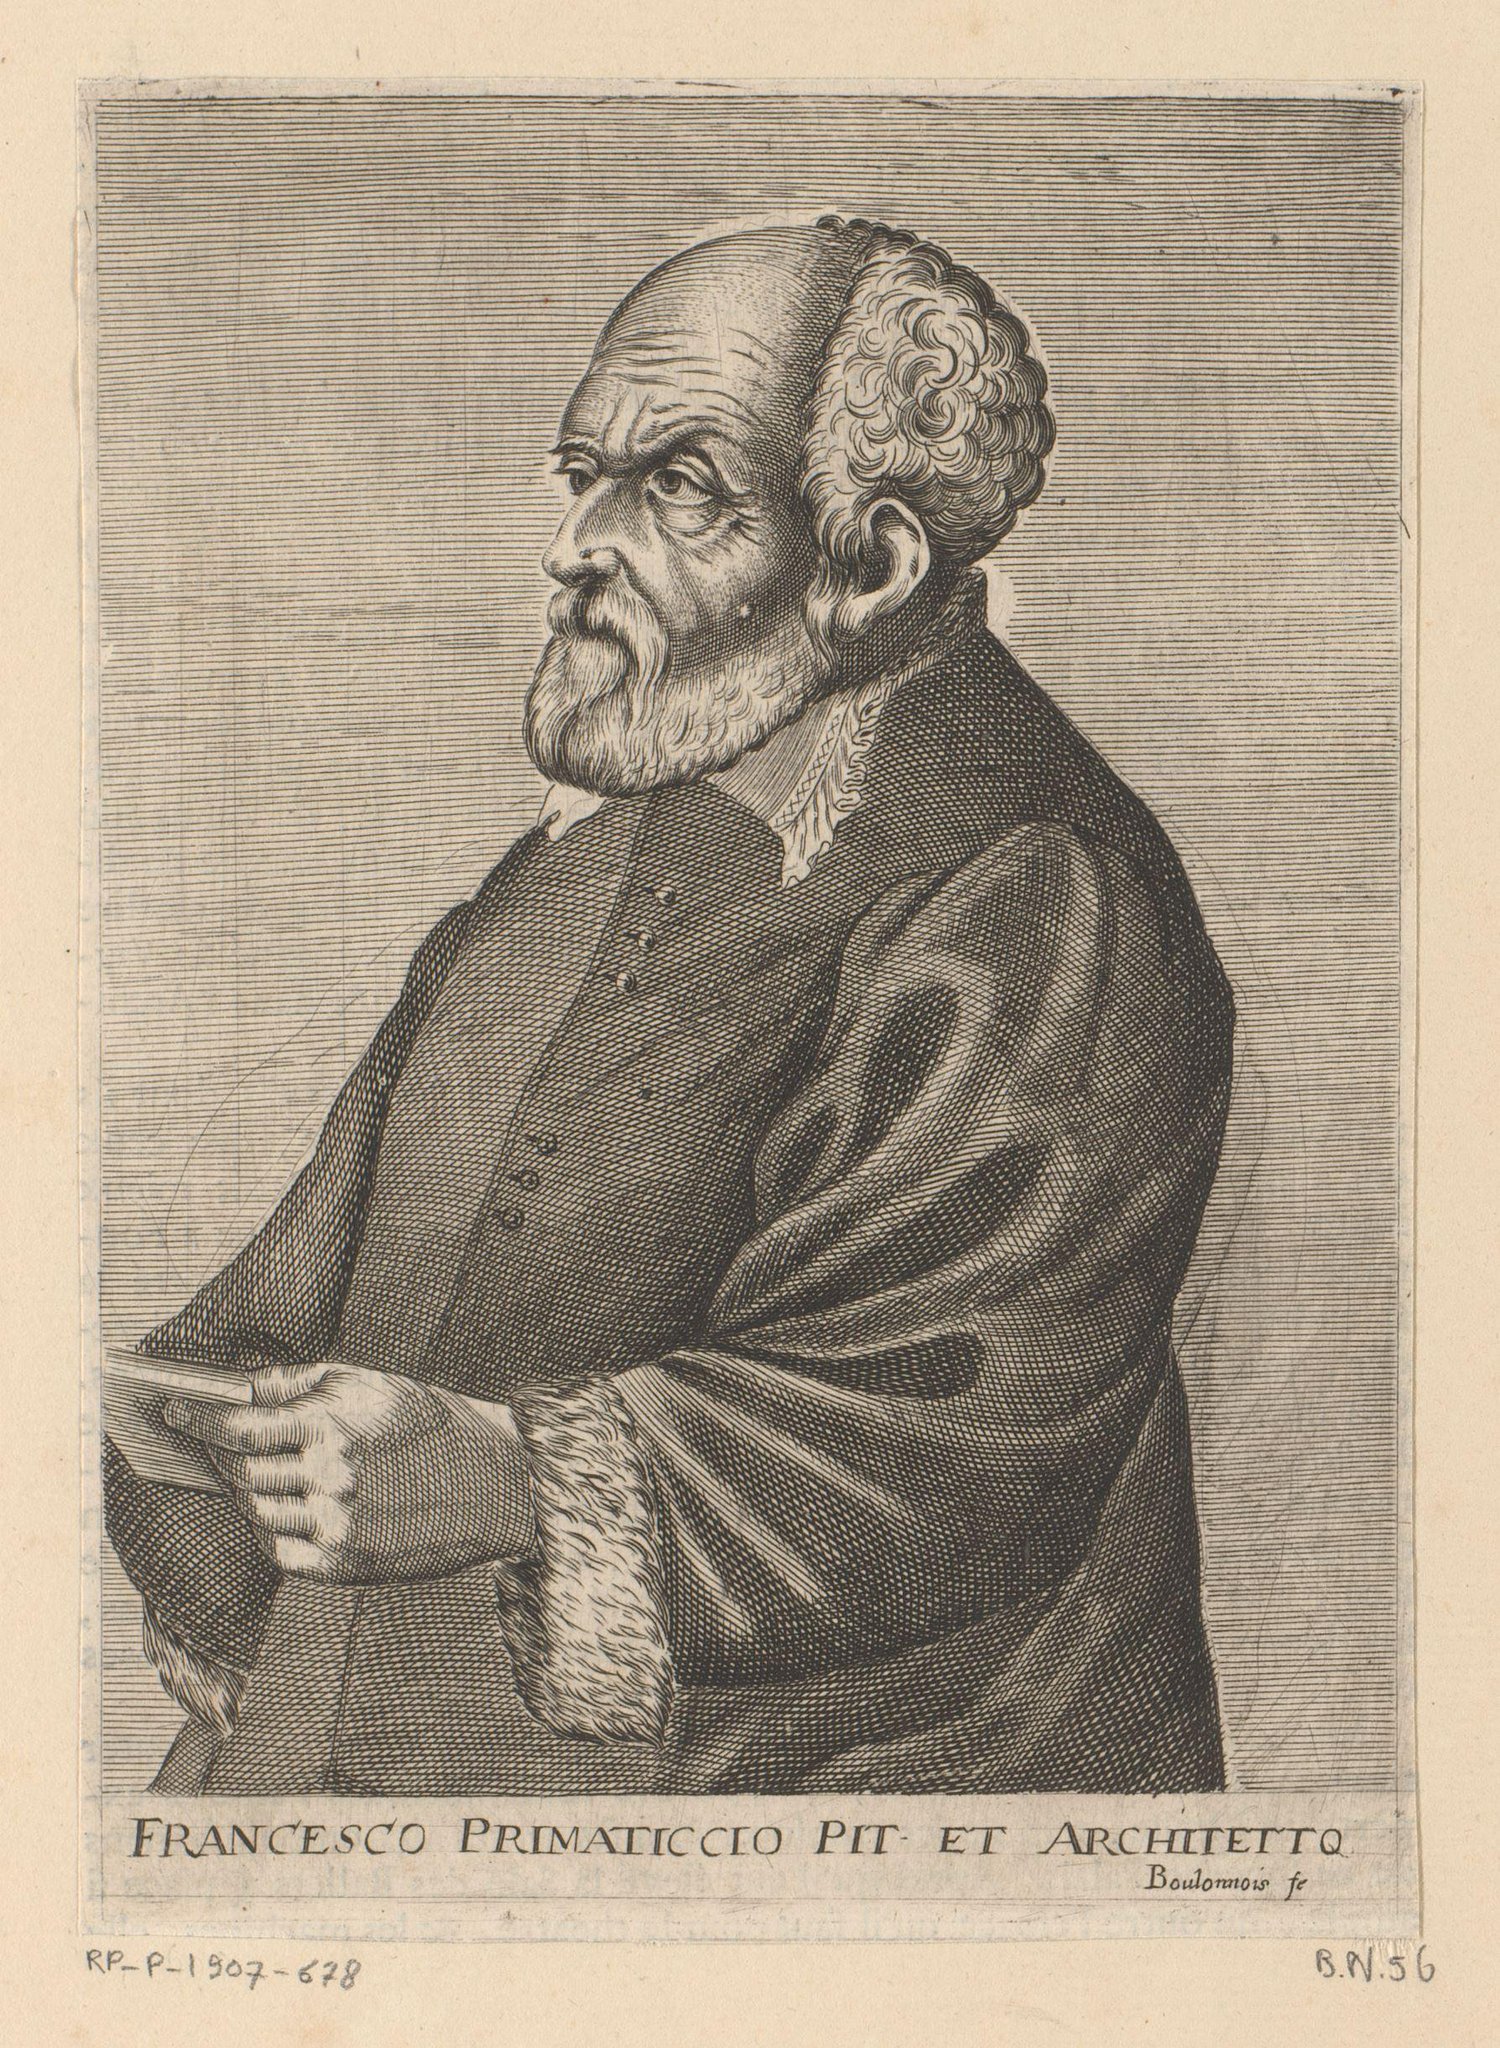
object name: print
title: Francesco Primaticcio Pit Et Architetto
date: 1682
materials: paper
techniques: engraving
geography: brussels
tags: paris, painter, draughtsman, sculptor, francesco primaticcio, historical persons, portrait, self-portrait of artist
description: Prent uit: Bullert, Isaac. Académie des Sciences et Arts contenant les vies et éloges his. des hommes illustres qui ont excellé en ces professions depuis environ quatre siècles. Brussel: Foppens, François, 1682. Het boek werd in 1682 eveneens in Amsterdam uitgegeven door de erfgenamen van Daniel Elzevier. Deze portretten dienen ter illustratie van de biografie van een kunstenaar of geleerde. De meeste portretten werden door Nicolas de Larmessin vervaardigd (162), 93 door De Boulonois en een derde door ongeïdentificeerde prentmakers. Dit betreft een illustratie op p. 417, deel I.